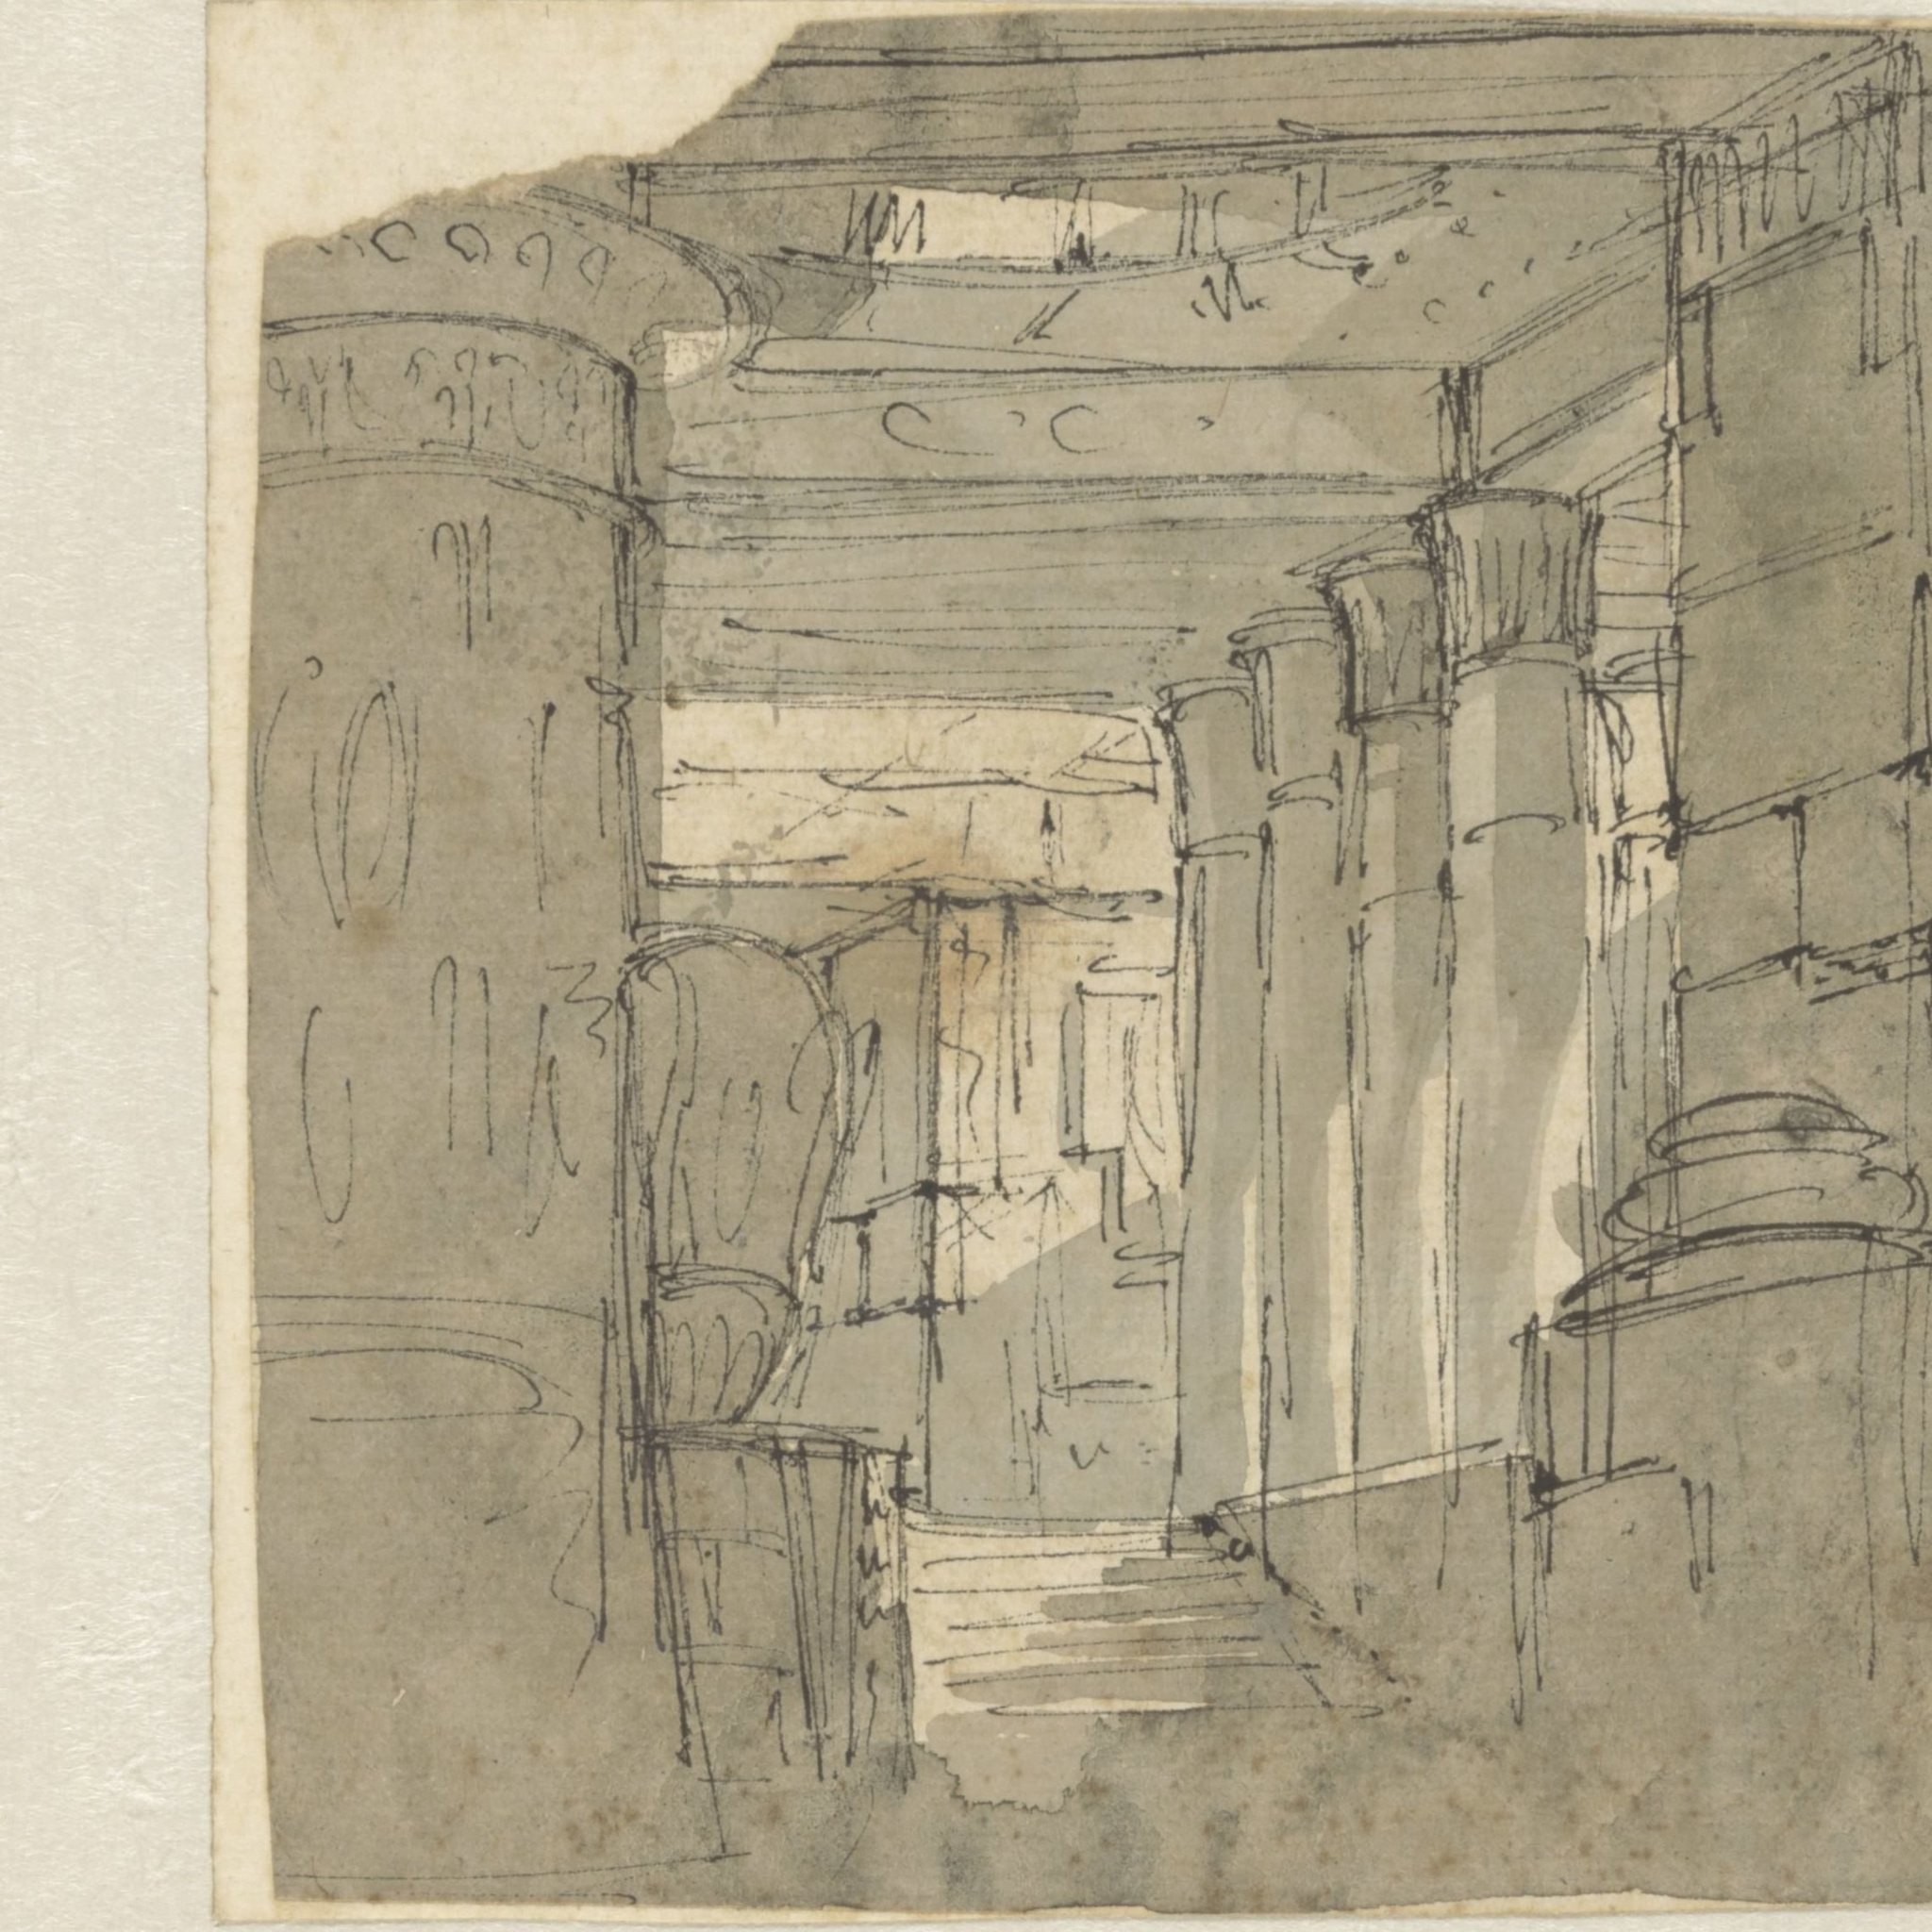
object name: drawing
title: Trapopgang in een Egyptisch aandoende tempel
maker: Anonymous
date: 1790-1810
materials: ink, paper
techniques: brush, pen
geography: italy